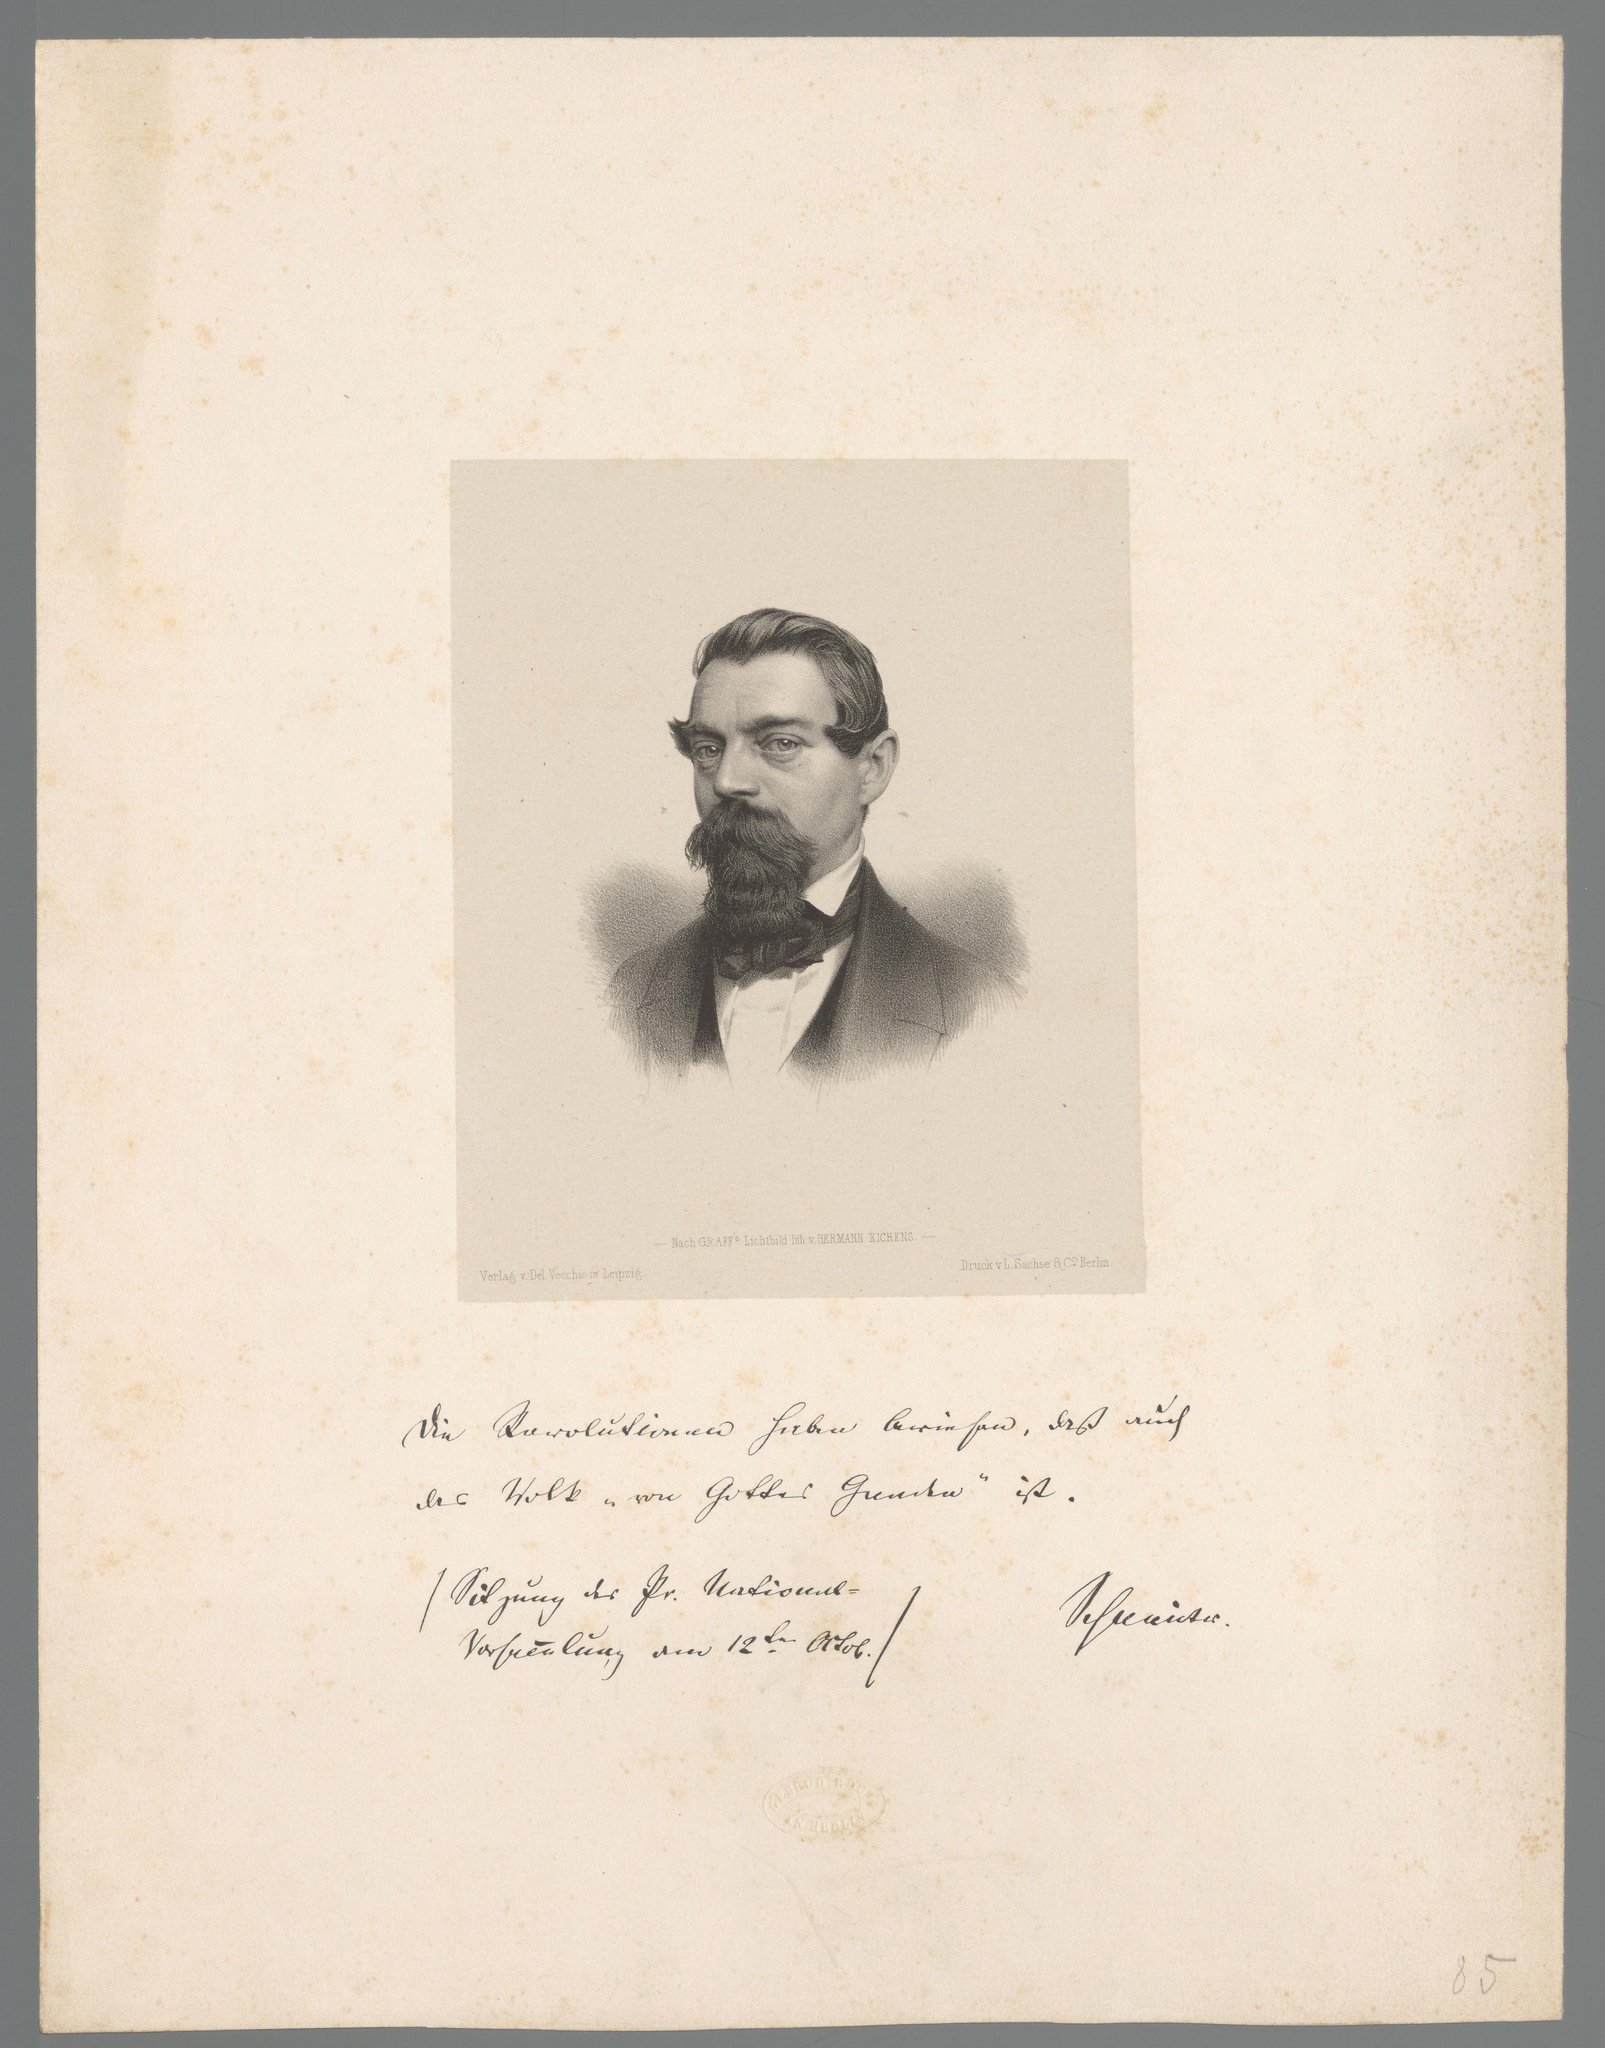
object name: print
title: Portret van een onbekende man, mogelijk Karl Ludwig Schneider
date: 1870-1886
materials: paper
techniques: lithograph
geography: leipzig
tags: historical persons not known by name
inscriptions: check stamp: Lugt 2141c, collector's mark: Lugt 2228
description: Portret van een verder onbekende man, met handtekening in facsimile waarin mogelijk de naam Schneider te lezen is.